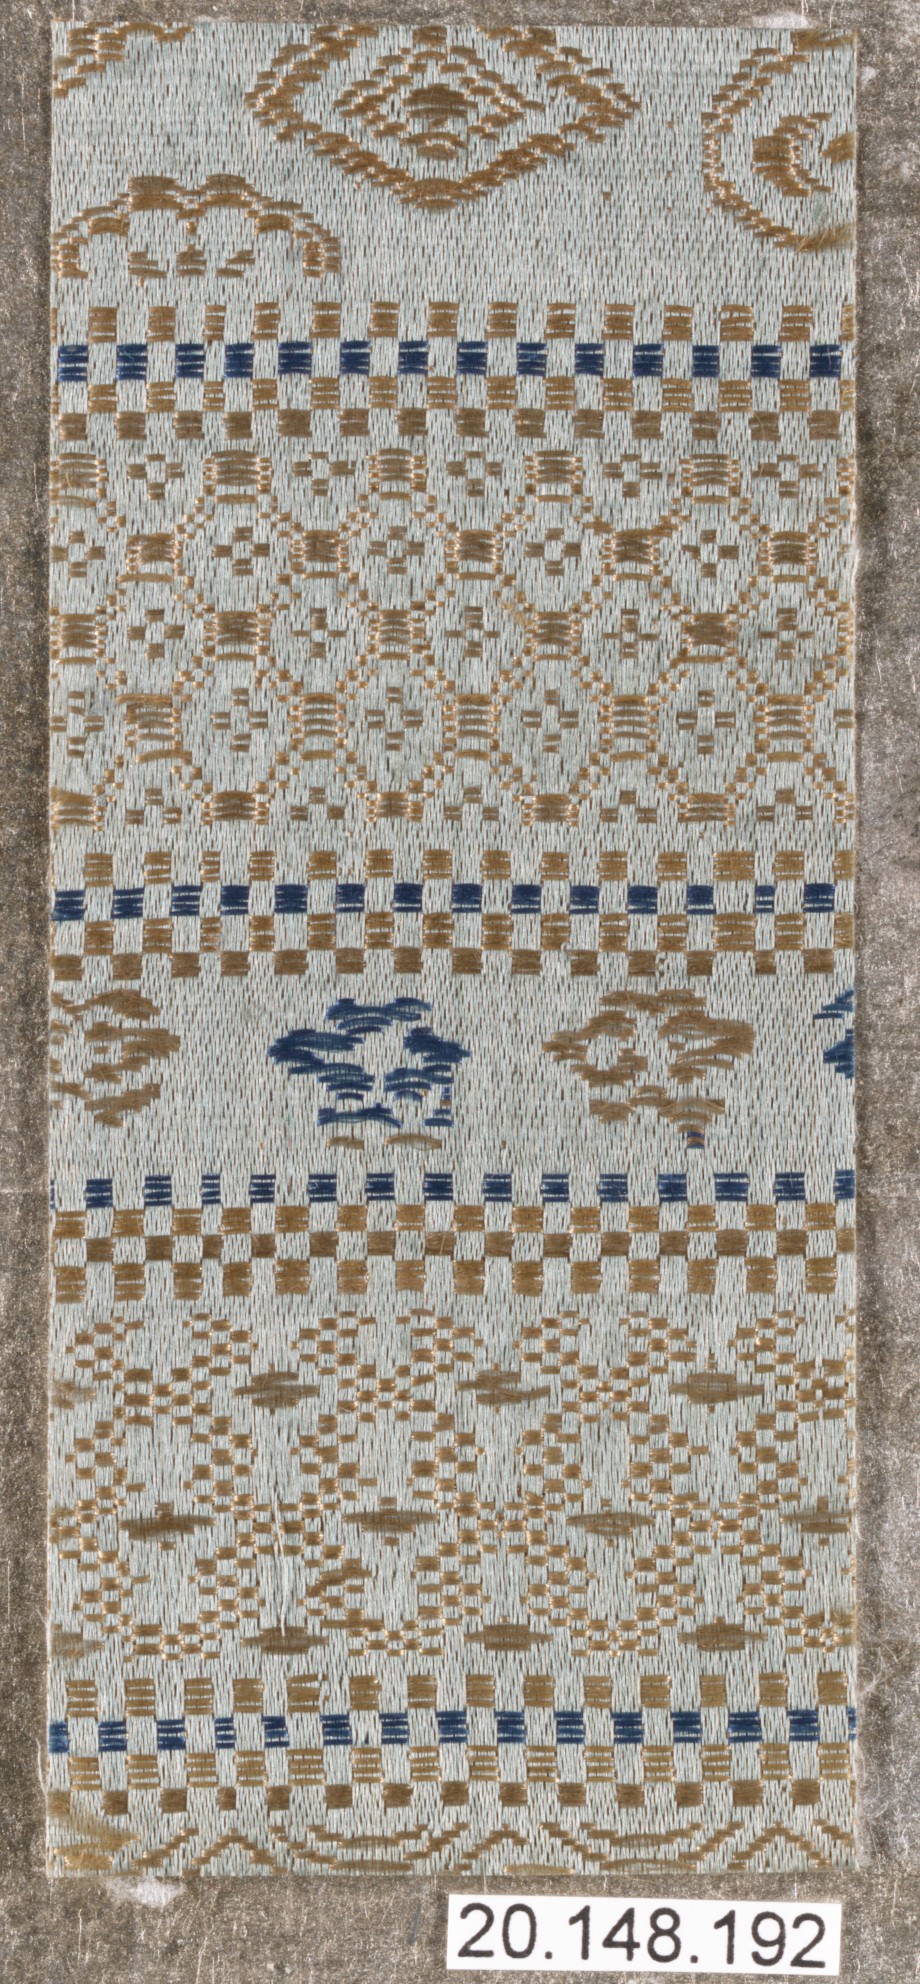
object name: piece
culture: japanese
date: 1701-1800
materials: silk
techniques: compound weave